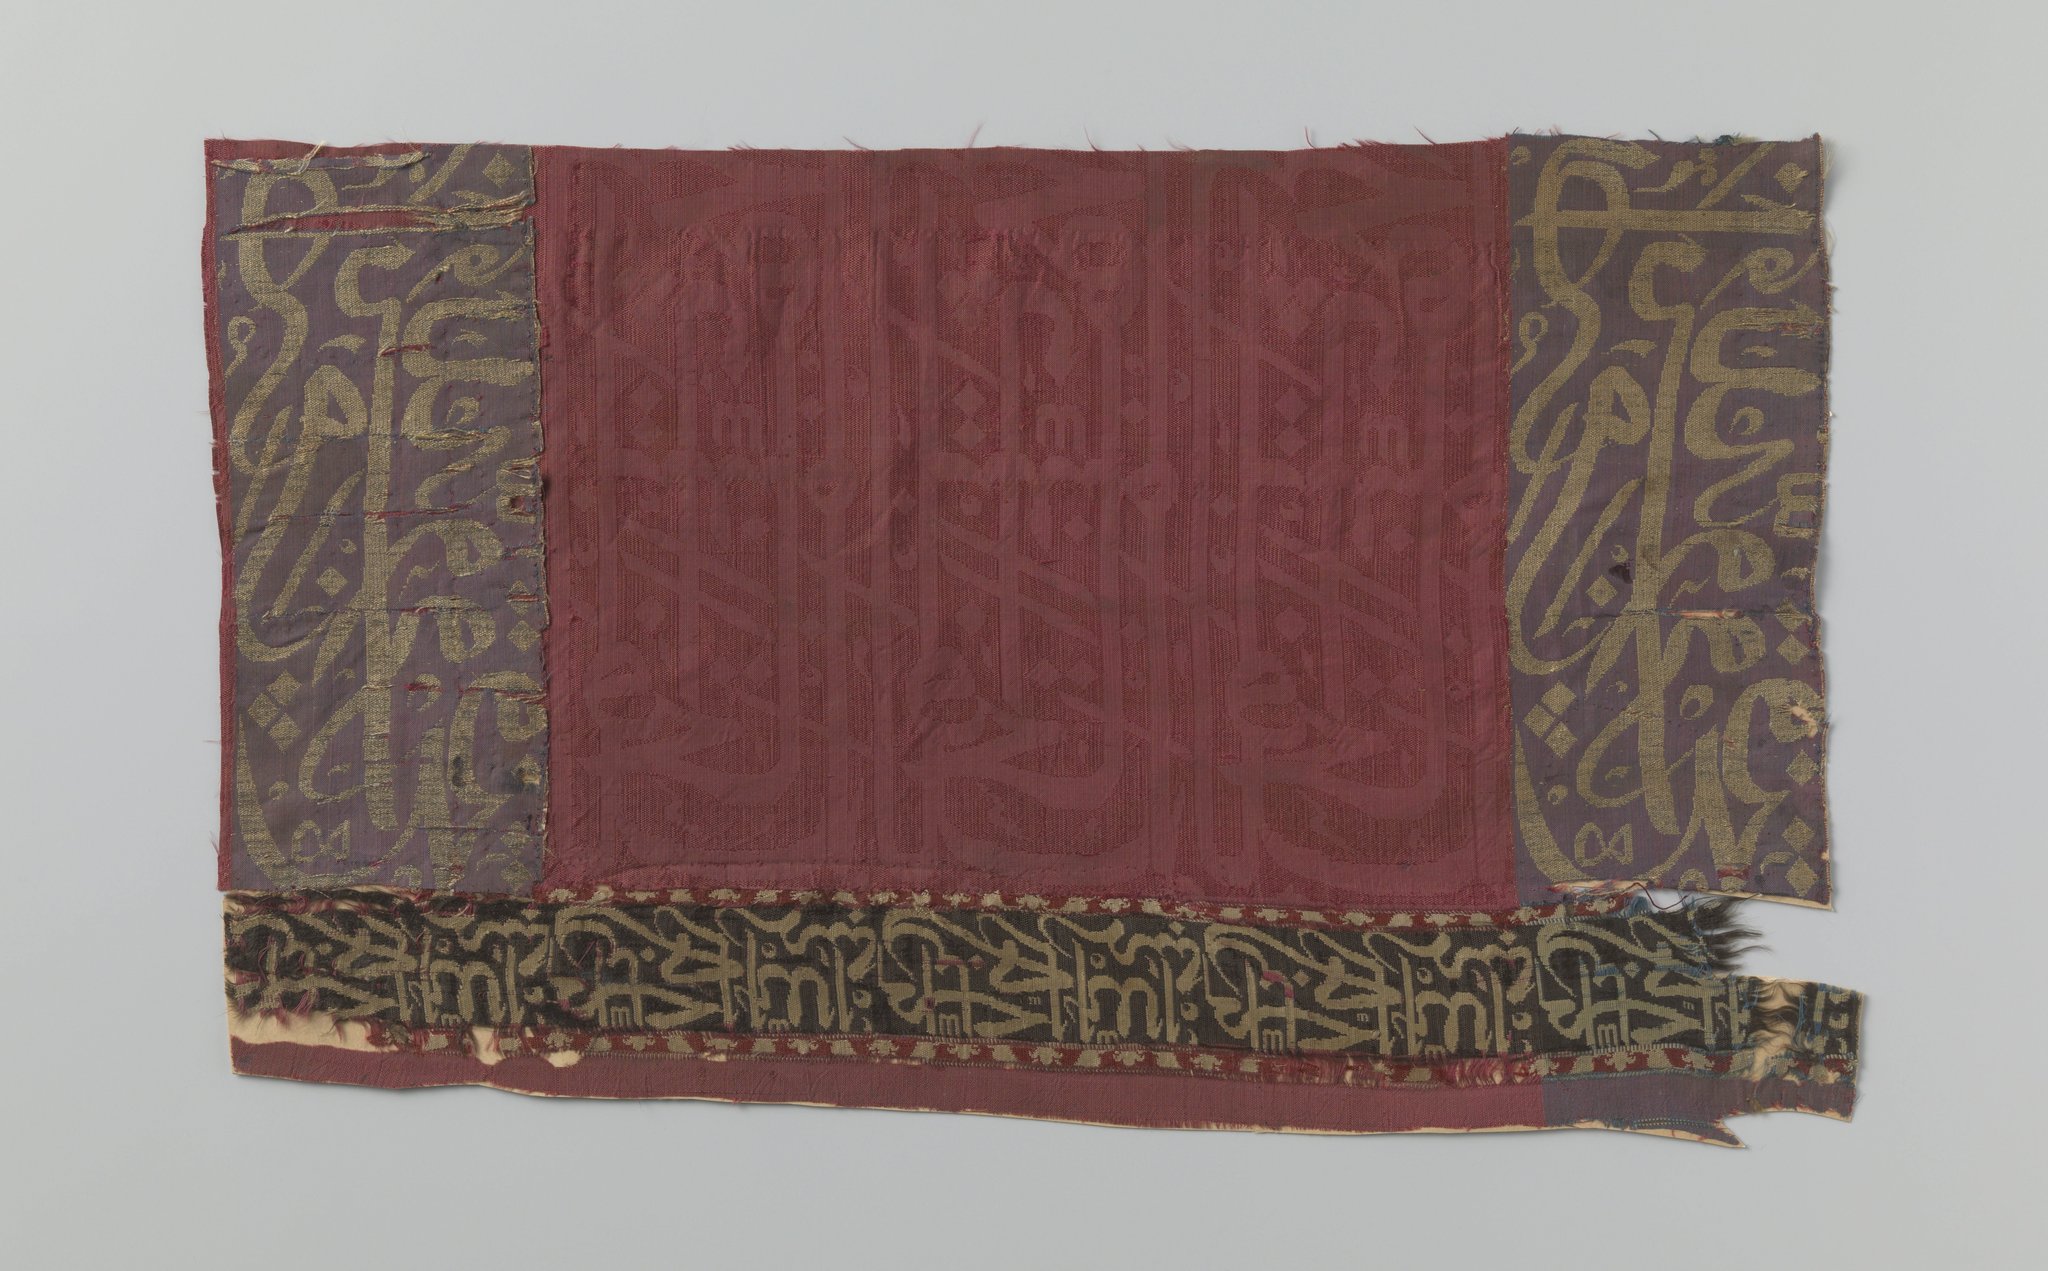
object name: zijdedamast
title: Fragment zijdedamast met ingeweven Arabische tekst en decoratieve banden met tekst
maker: Anonymous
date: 1400-1499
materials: silk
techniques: damask, weave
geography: middle east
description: Fragment rode zijde met langs drie zijden banden met lettertekens op donkere grond. Een band is aangenaaid.